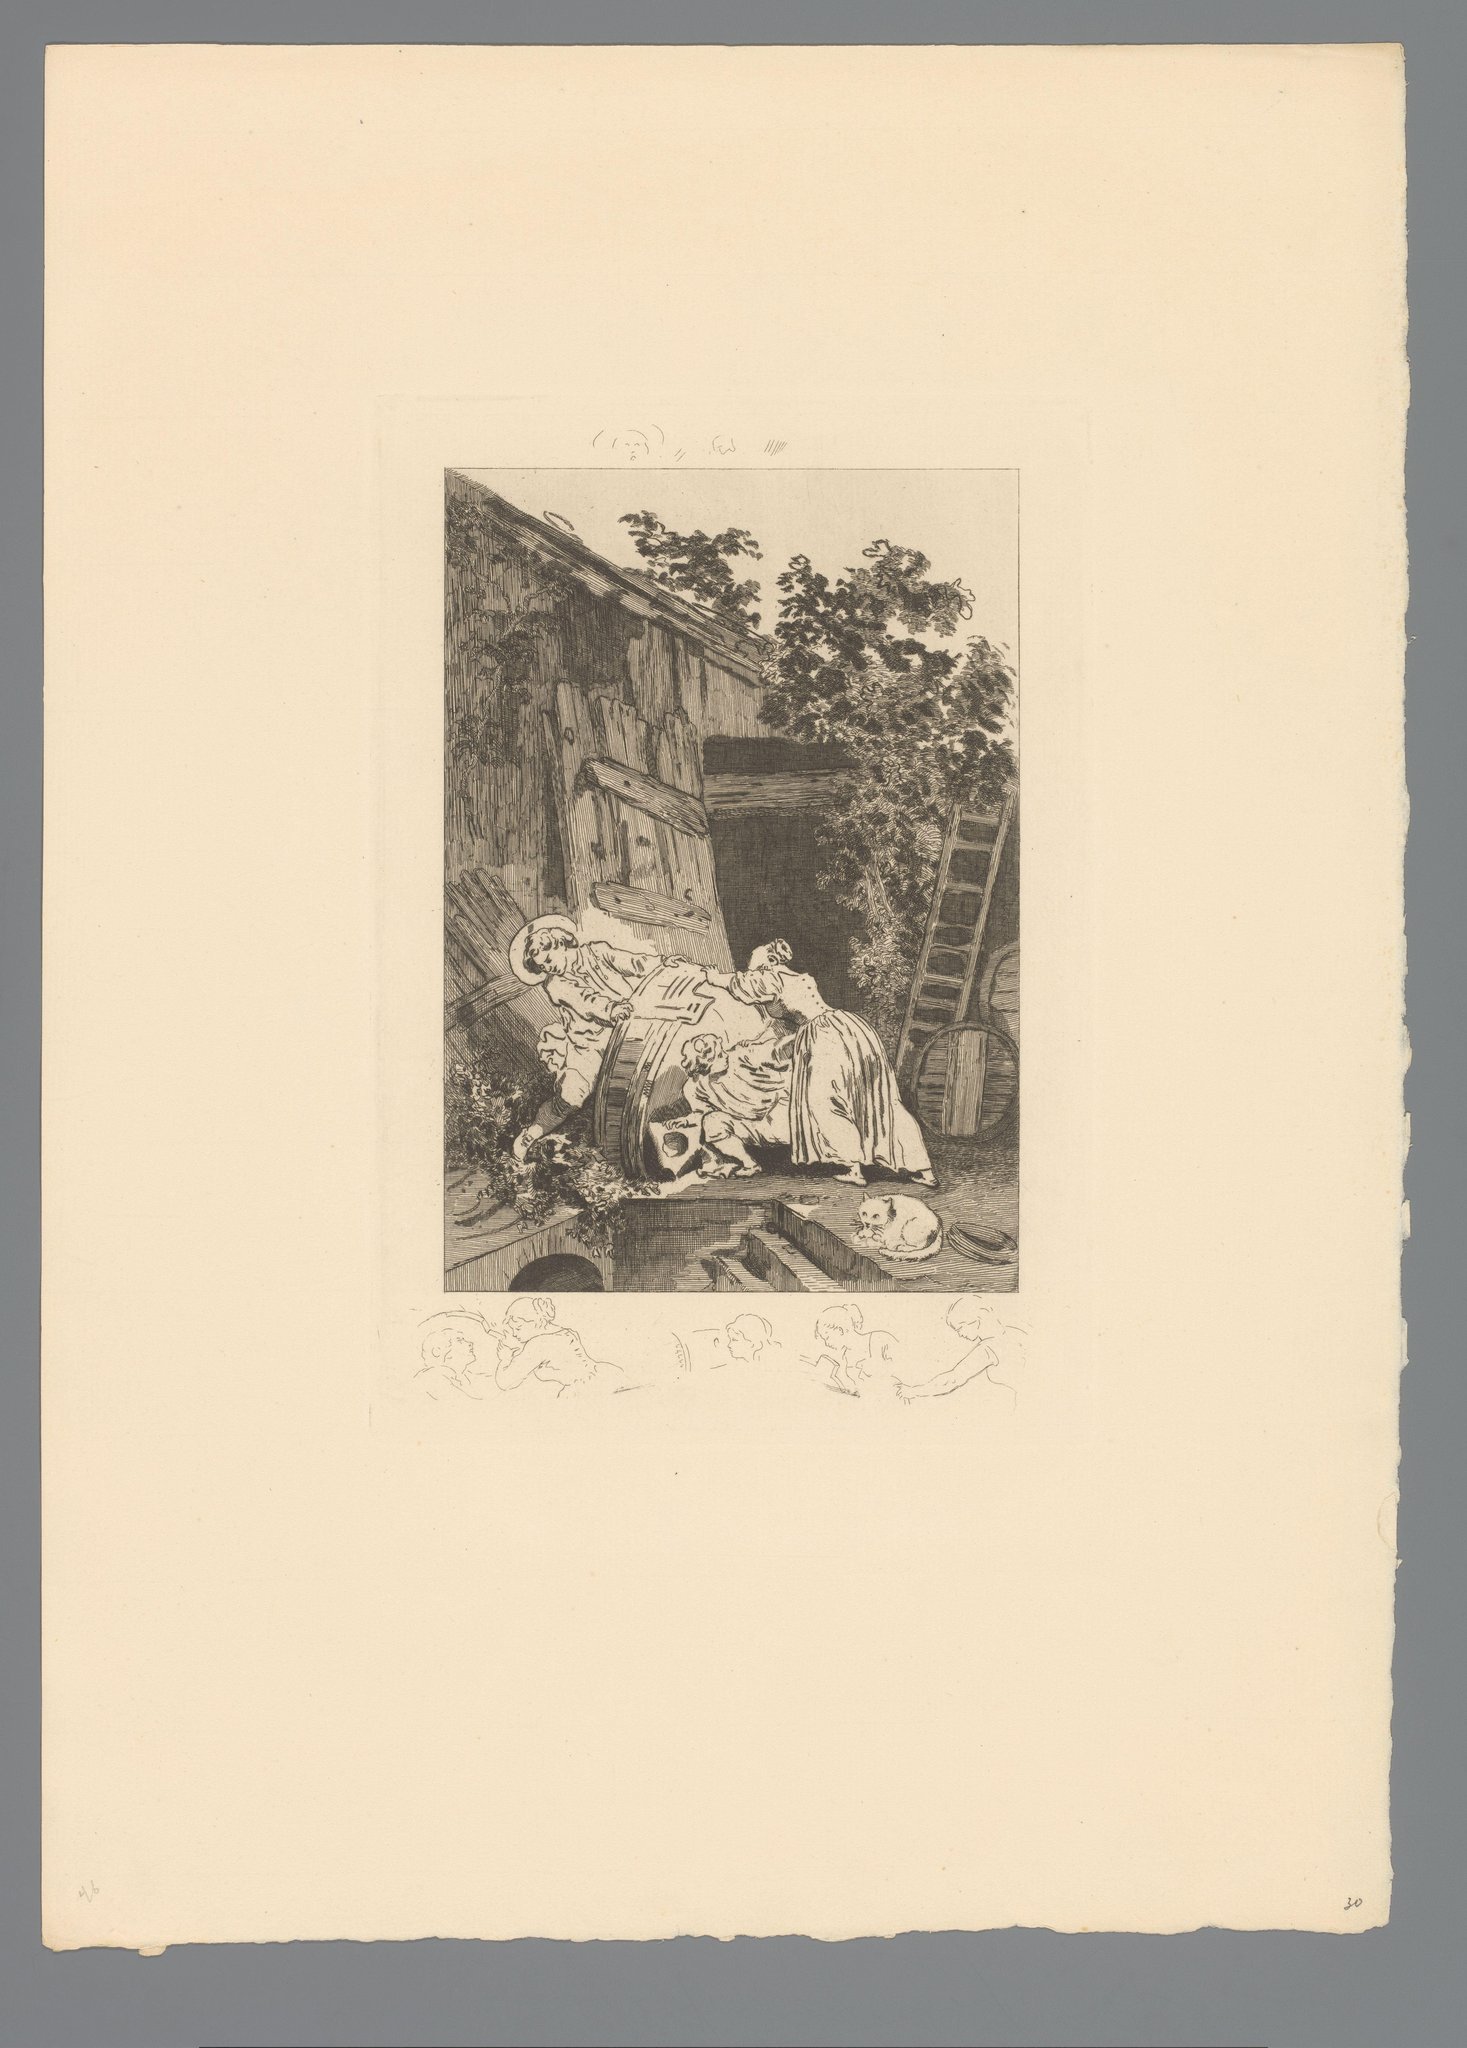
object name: photomechanical print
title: Reproductie van een prent naar een tekening van een paar die de man ontdekt die hen begluurd heeft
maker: Anonymous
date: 1880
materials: paper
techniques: photoaquatint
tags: lovers spied upon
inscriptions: collector's mark: Lugt 2228, collector's mark:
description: Martial Potémont maakte etsen naar de tekeningen van Fragonard, die zich bevonden in een manuscript in de collectie van de verzamelaar Eugène Paillet. Rouquette bood hem aan de tekeningen zo exact mogelijk in prent te laten brengen door Martial Potémont: dit resulteerde in een serie van 57 etsen. Vervolgens werden deze gereproduceerd door middel van heliogravure. Deze omslag betreft een editie voor de letter, "Eau forte pure", de 1e staat van 3 waar men uit kon kiezen bij deze serie.